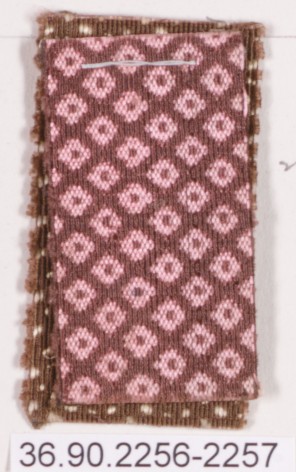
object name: piece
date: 1801-1900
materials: silk